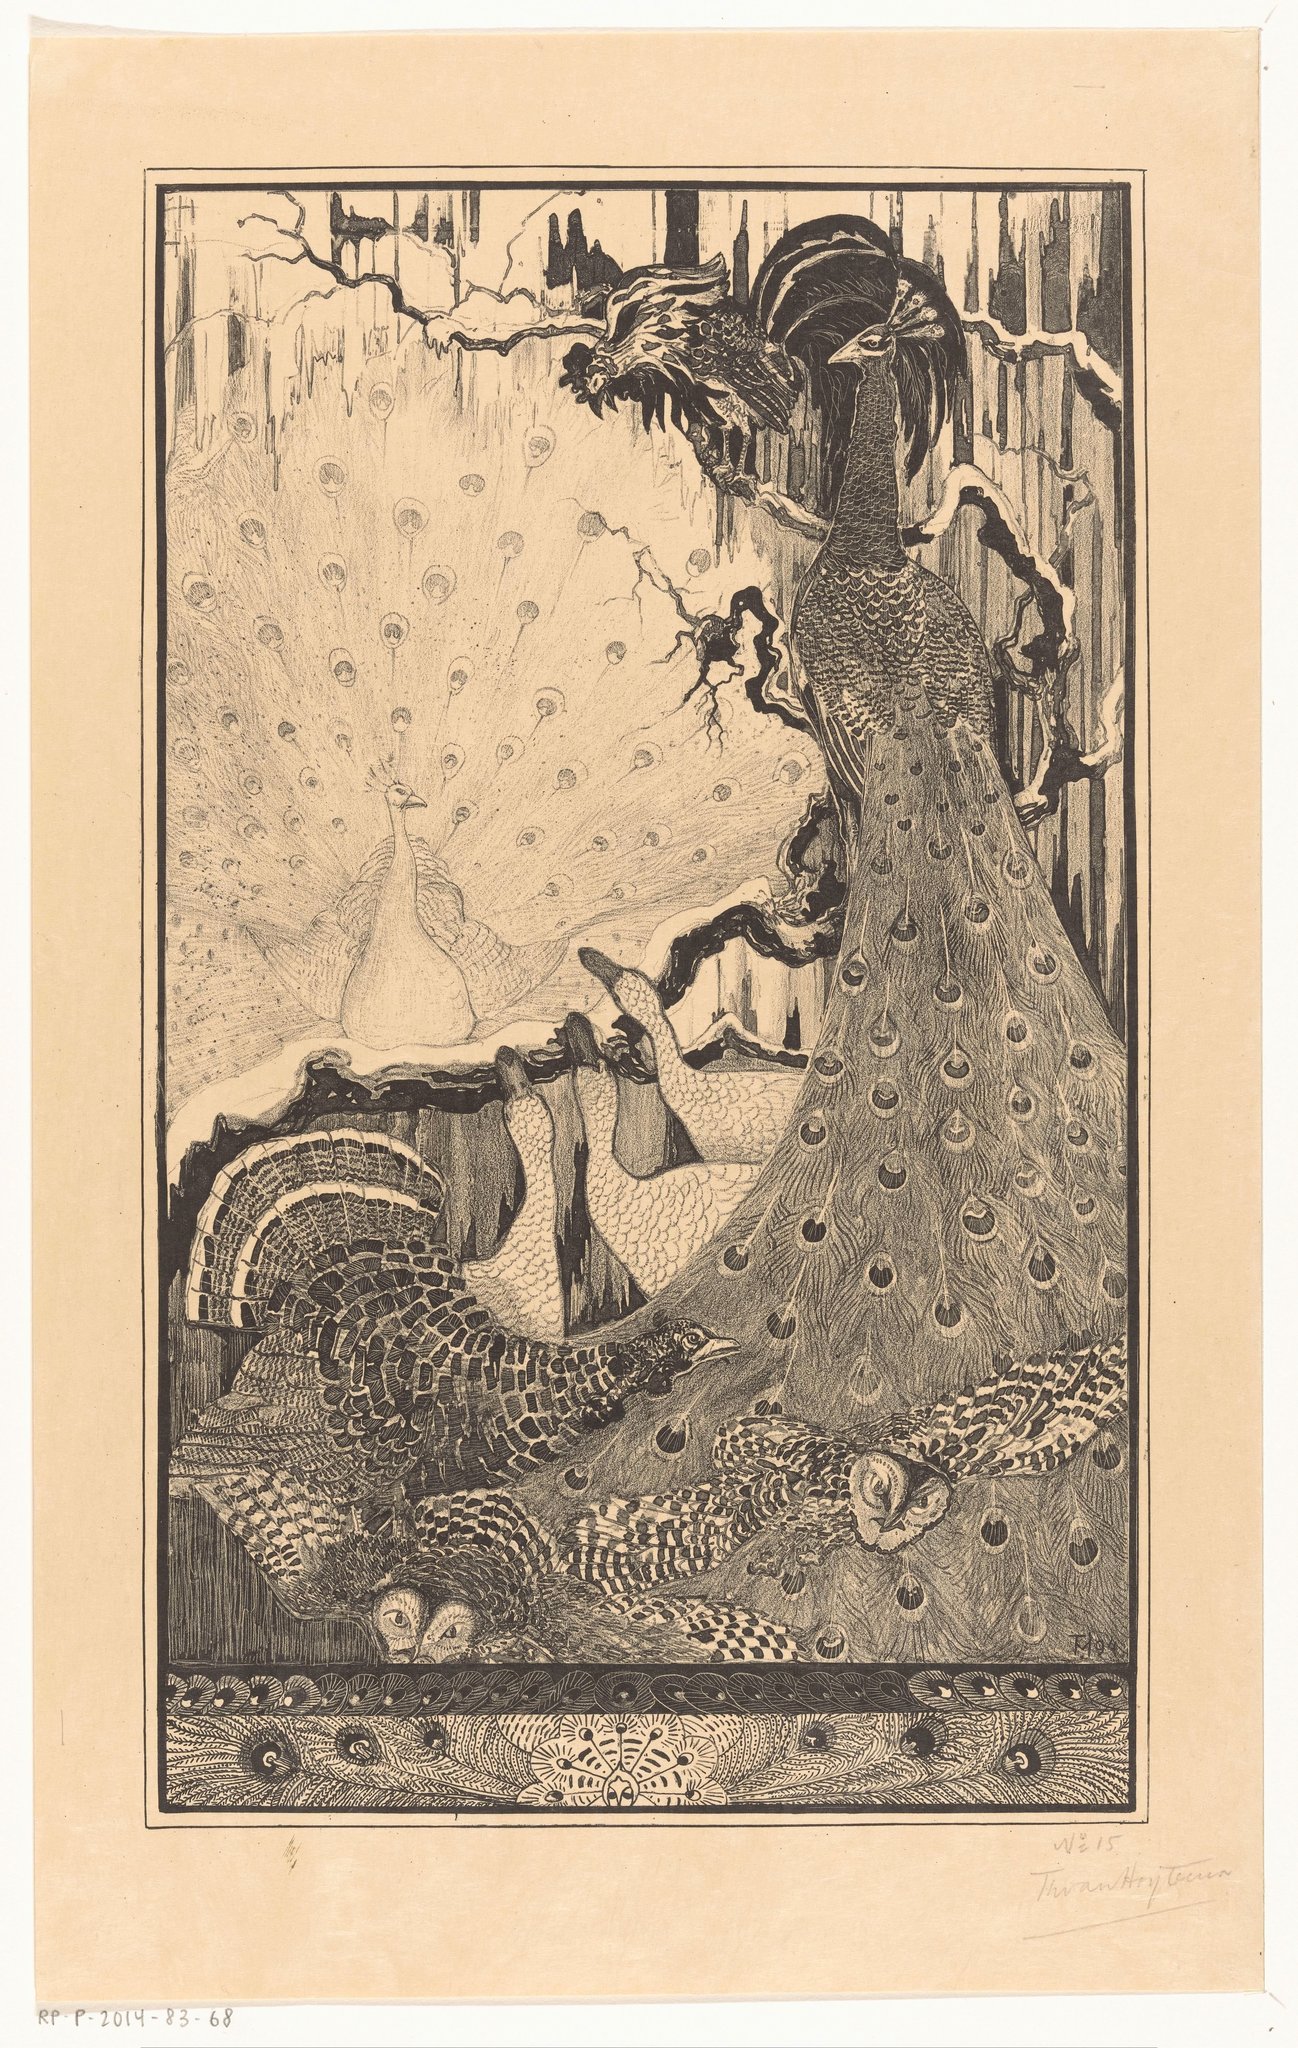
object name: print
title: Nieuwjaar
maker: theo van hoytema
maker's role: draughtsman, painter, print maker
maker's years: 1863-1917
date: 1894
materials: paper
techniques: lithograph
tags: birds, new year's eve (december 31)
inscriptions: collector's mark: Lugt 2228, number: ‘15’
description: Een donkere pauw, een symbool voor het oude jaar, bekijkt een lichtere pauw, symbool voor het nieuwe jaar. Op de voorgrond twee uilen en een korhoen. Op de achtergrond drie ganzen en een haan.